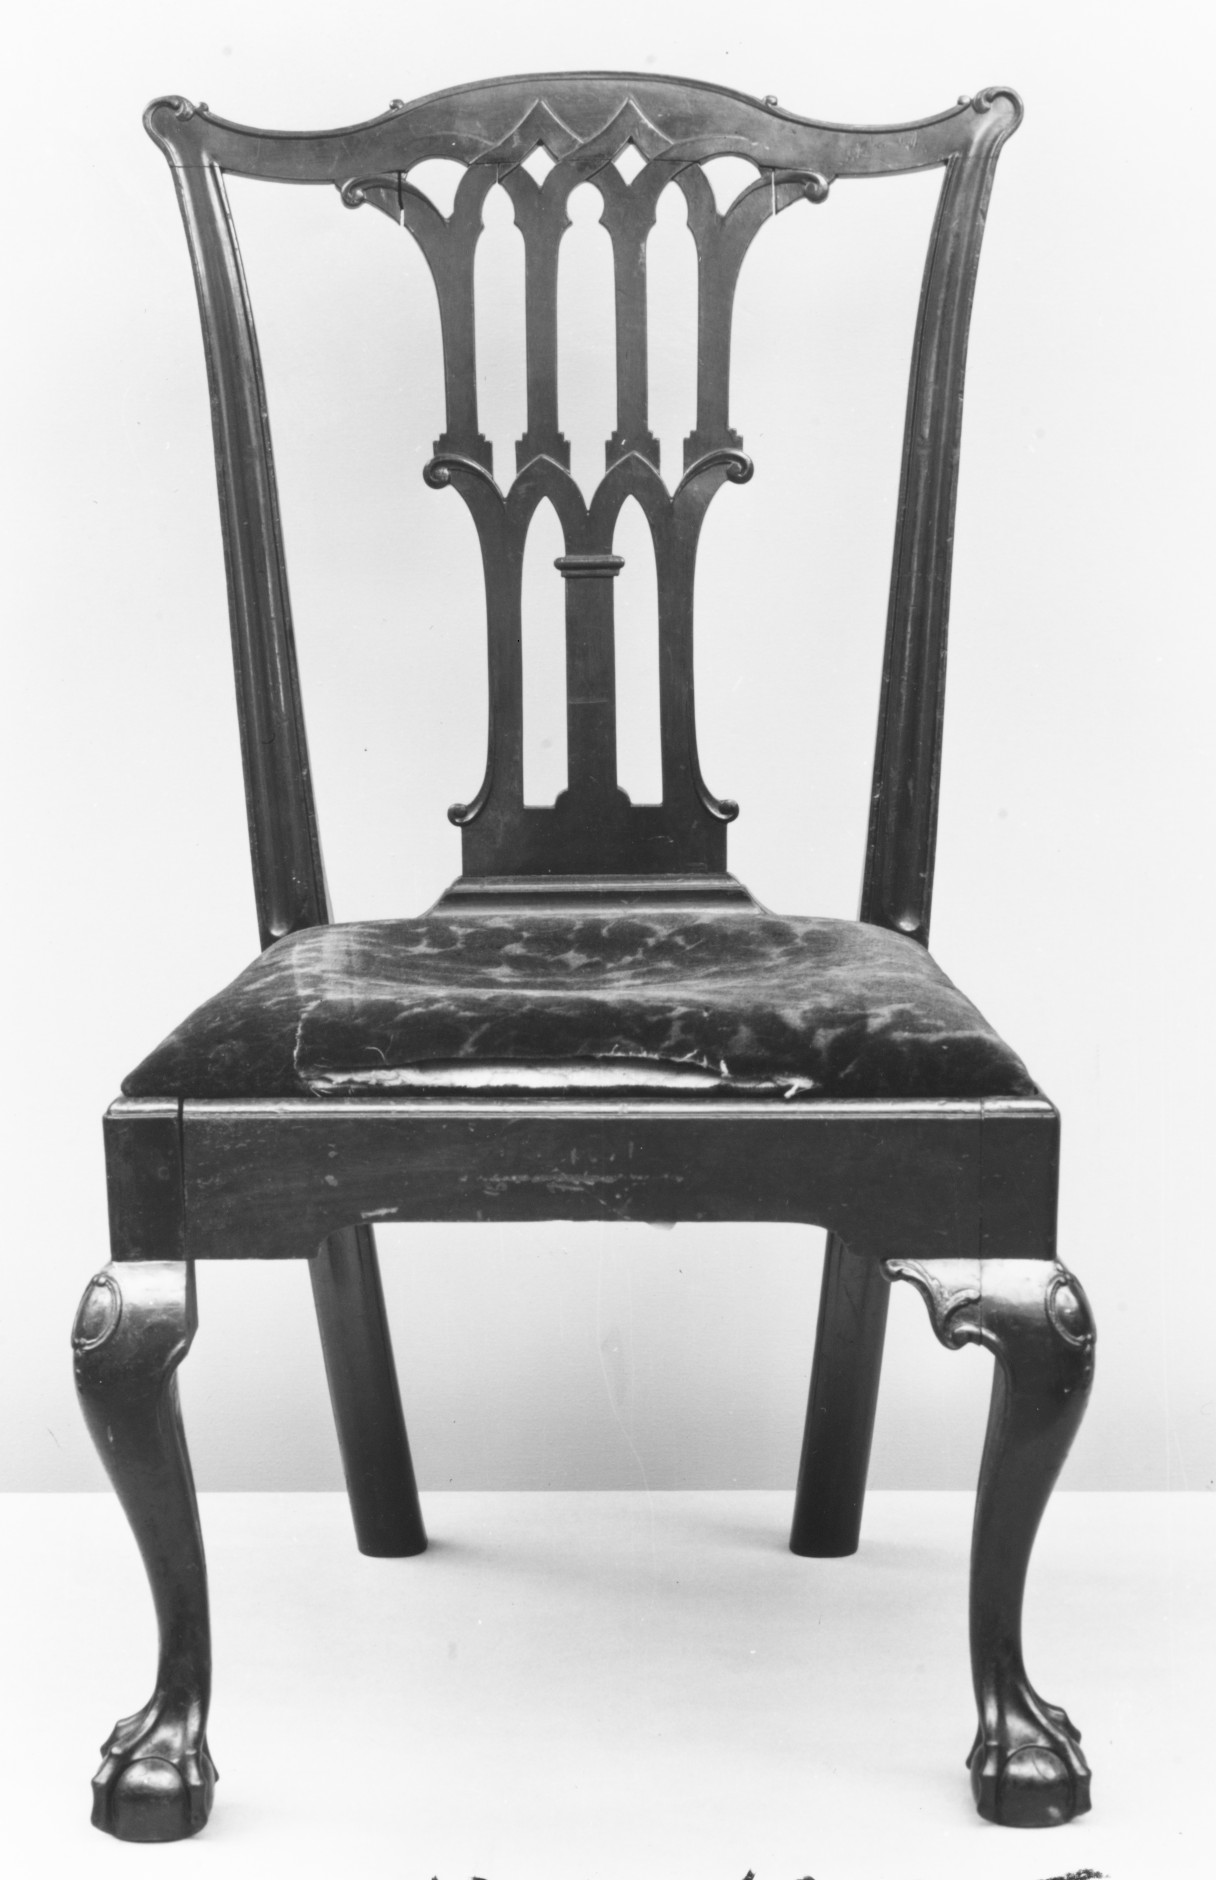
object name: side chair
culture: american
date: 1760-1790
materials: wood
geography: united states